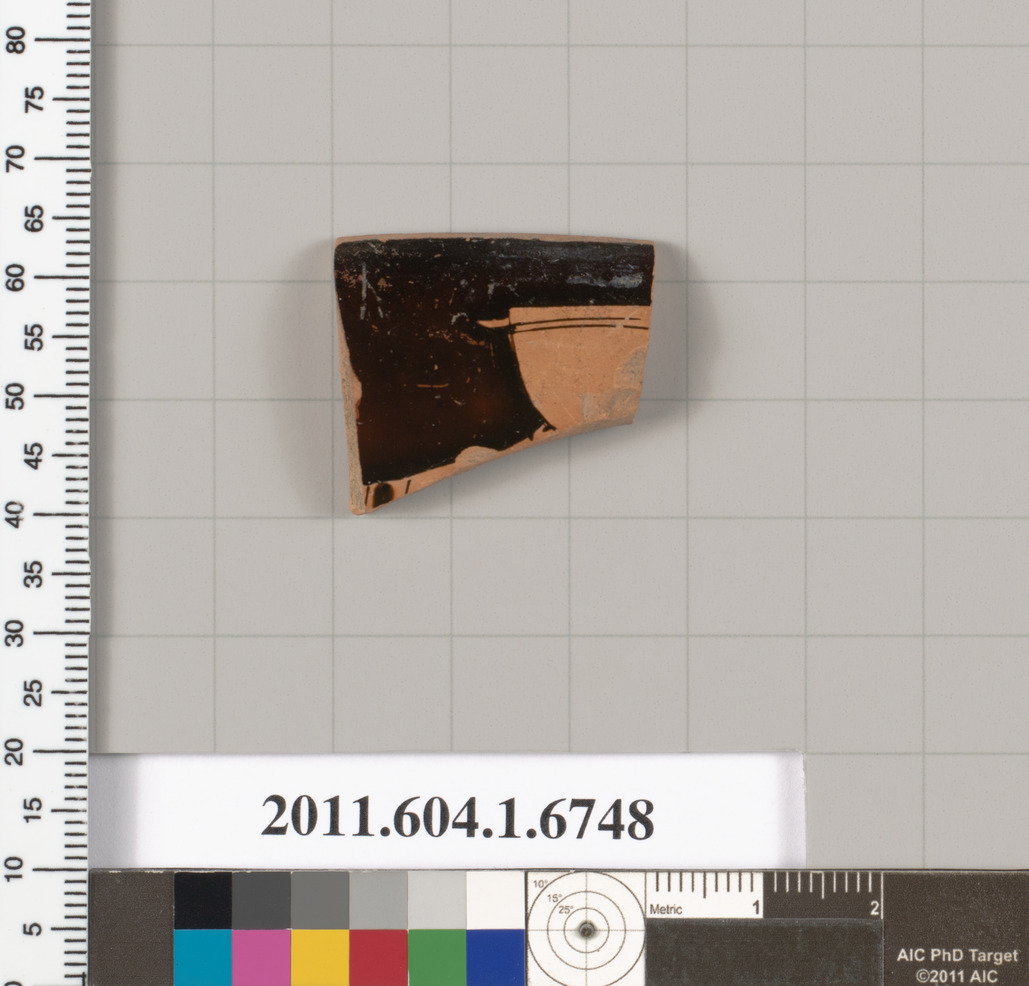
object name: kylix fragment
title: Terracotta rim fragment of a kylix (drinking cup)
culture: greek, attic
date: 490-470 BCE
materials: terracotta